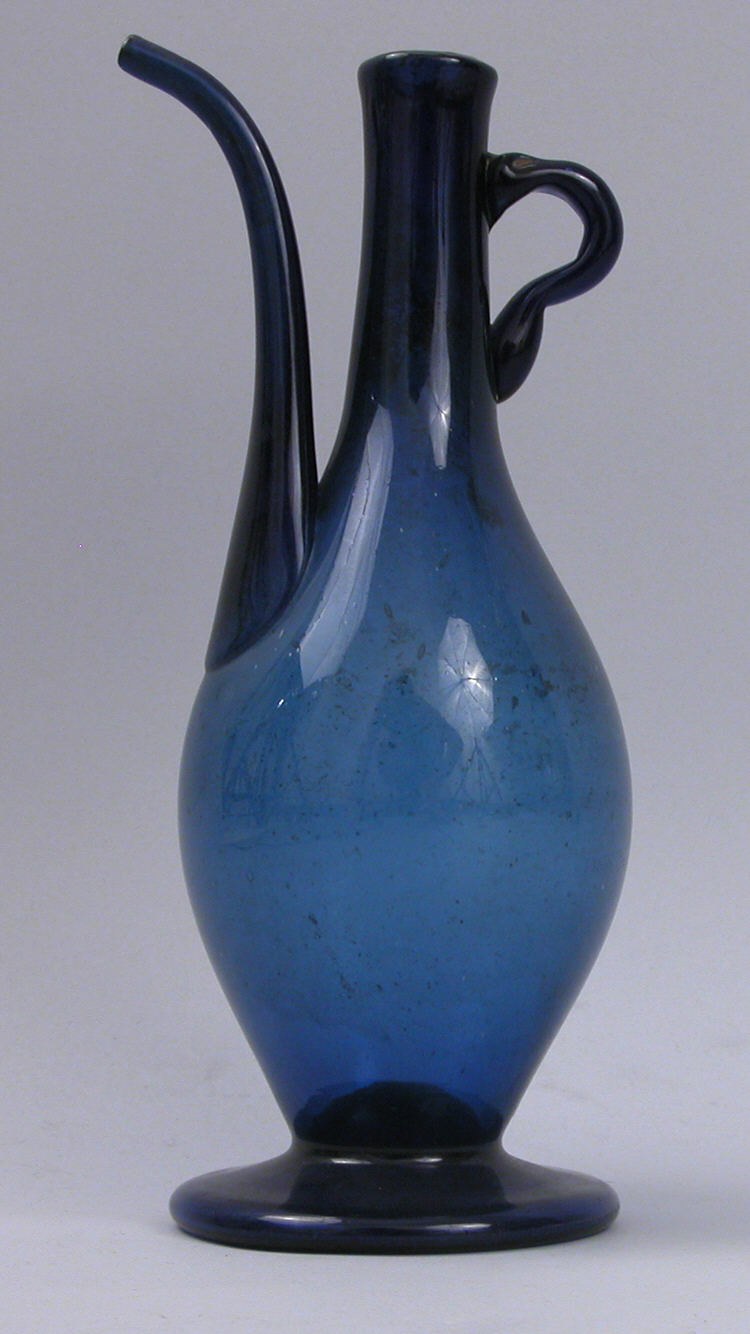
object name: ewer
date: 1701-1900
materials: glass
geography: iran